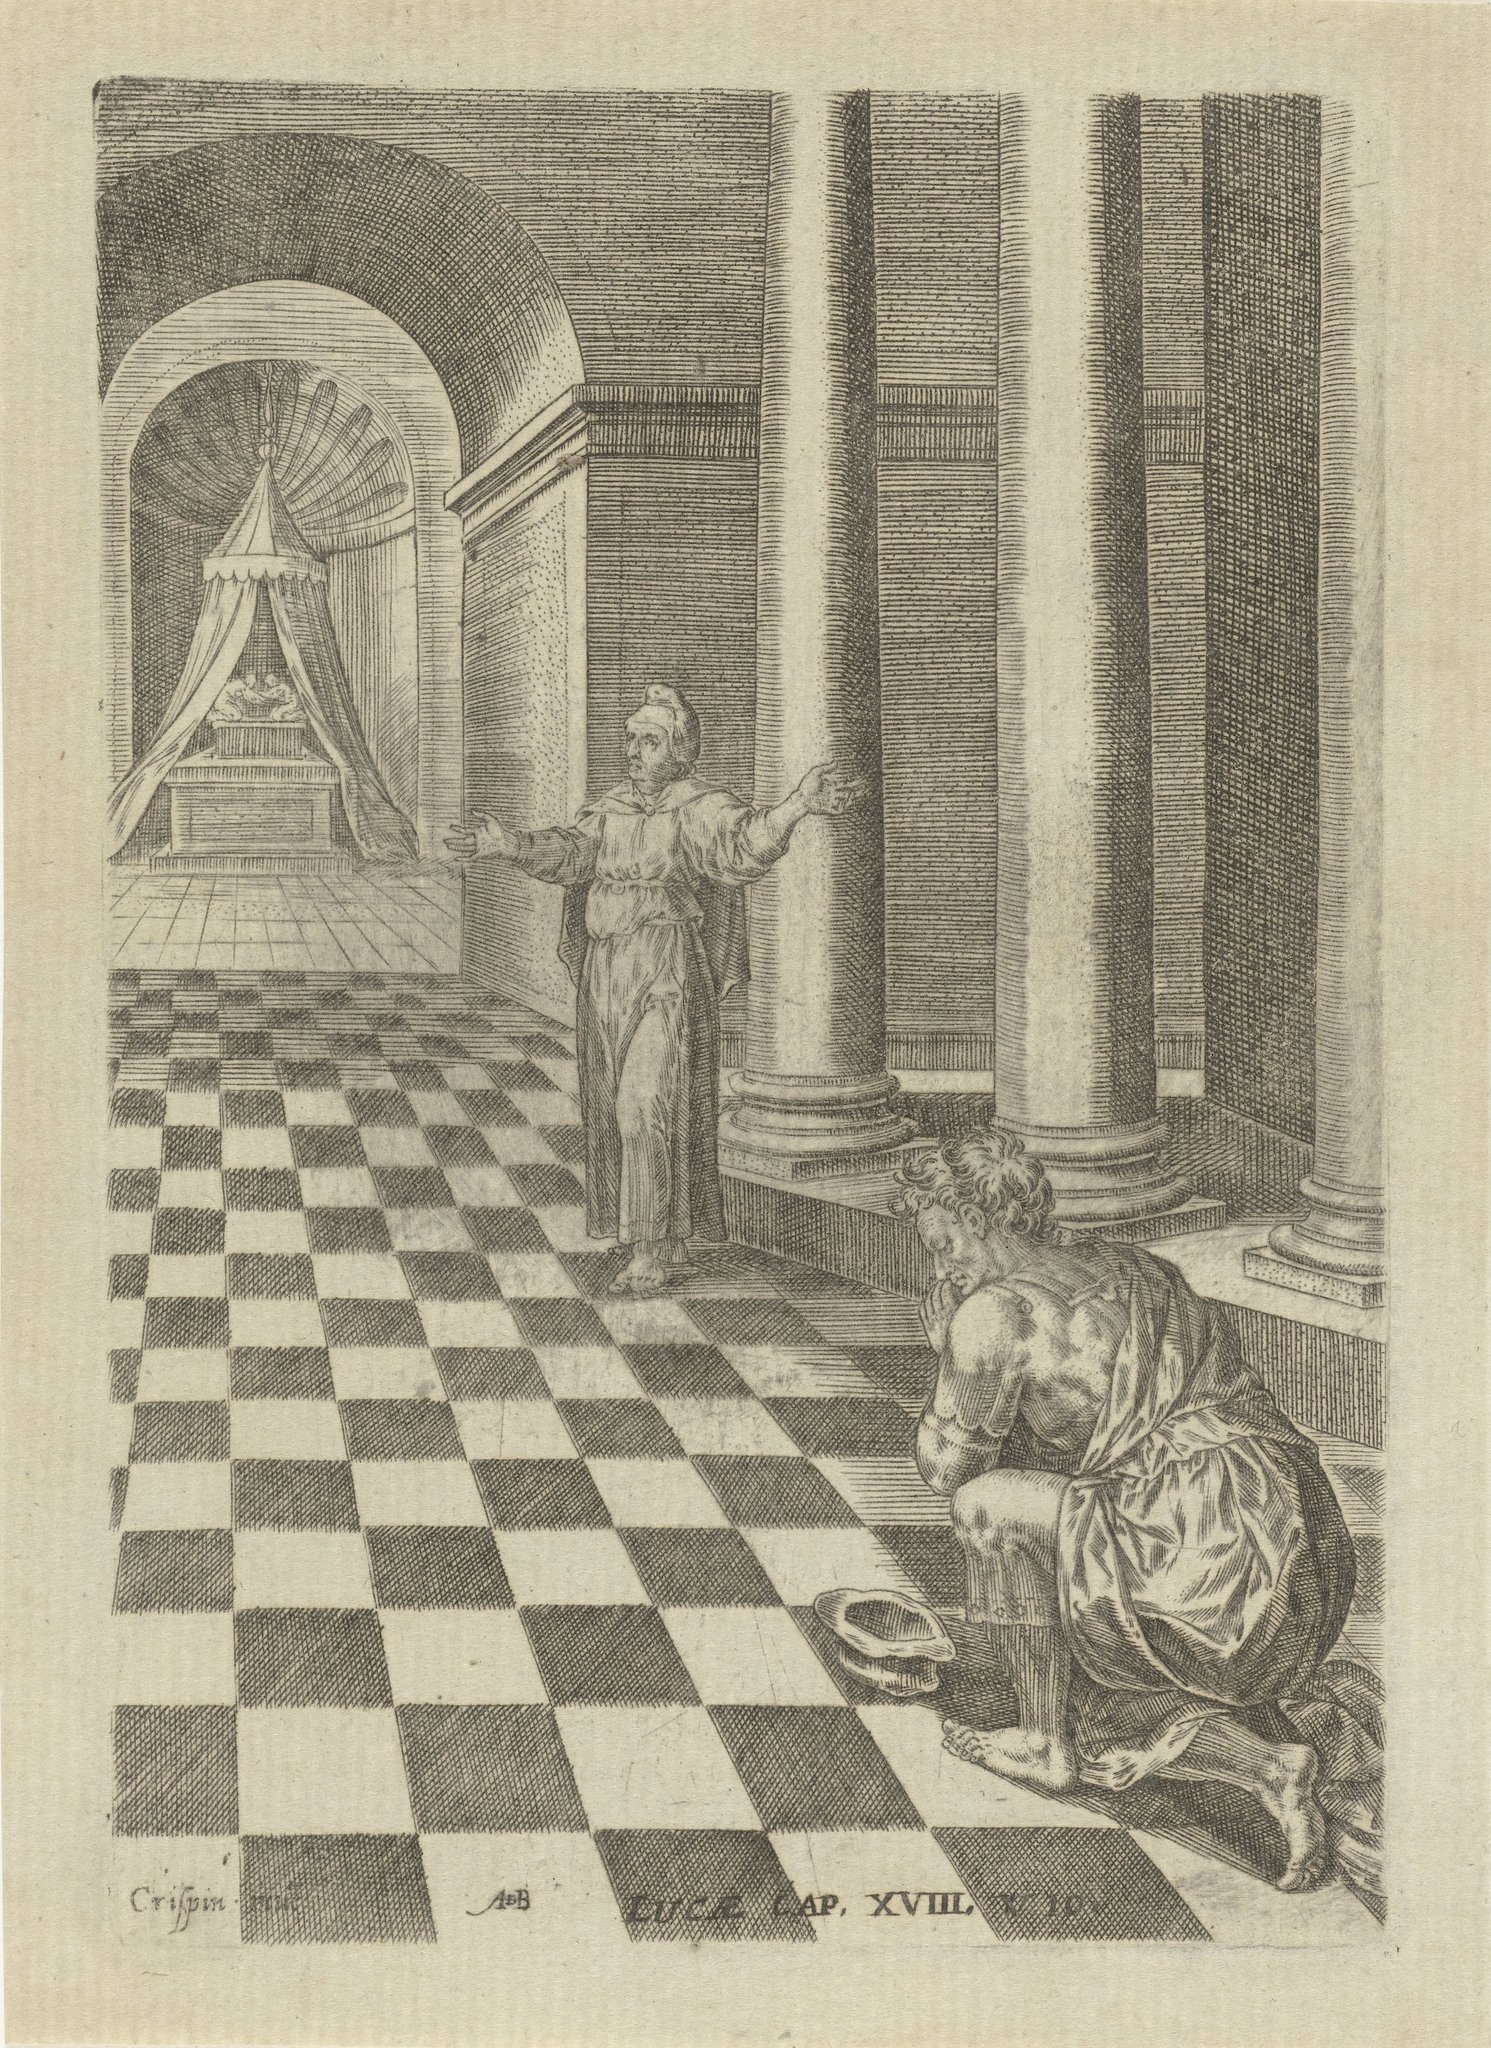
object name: print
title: Scènes uit de bijbel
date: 1583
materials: paper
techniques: engraving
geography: antwerp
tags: the praying pharisee and the repentant publican in the temple (luke 18:10-14)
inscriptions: collector's mark: Lugt 2228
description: Boekillustratie bij de parabel van de tollenaar en de Farizeeër (Lucas 18:9-14). Een tollenaar en een Farizeeër bidden samen in de tempel. De Farizeeër knielt niet uit nederigheid en acht zichzelf beter dan alle anderen. Hij dankt God voor dit geluk. De tollenaar weet dat hij zondig is en smeekt al knielend vergiffenis. Door deze nederigheid is de tollenaar het meest rechtvaardig. De prent bevat een onderschrift met een verwijzing naar de bijhorende Bijbelpassage.